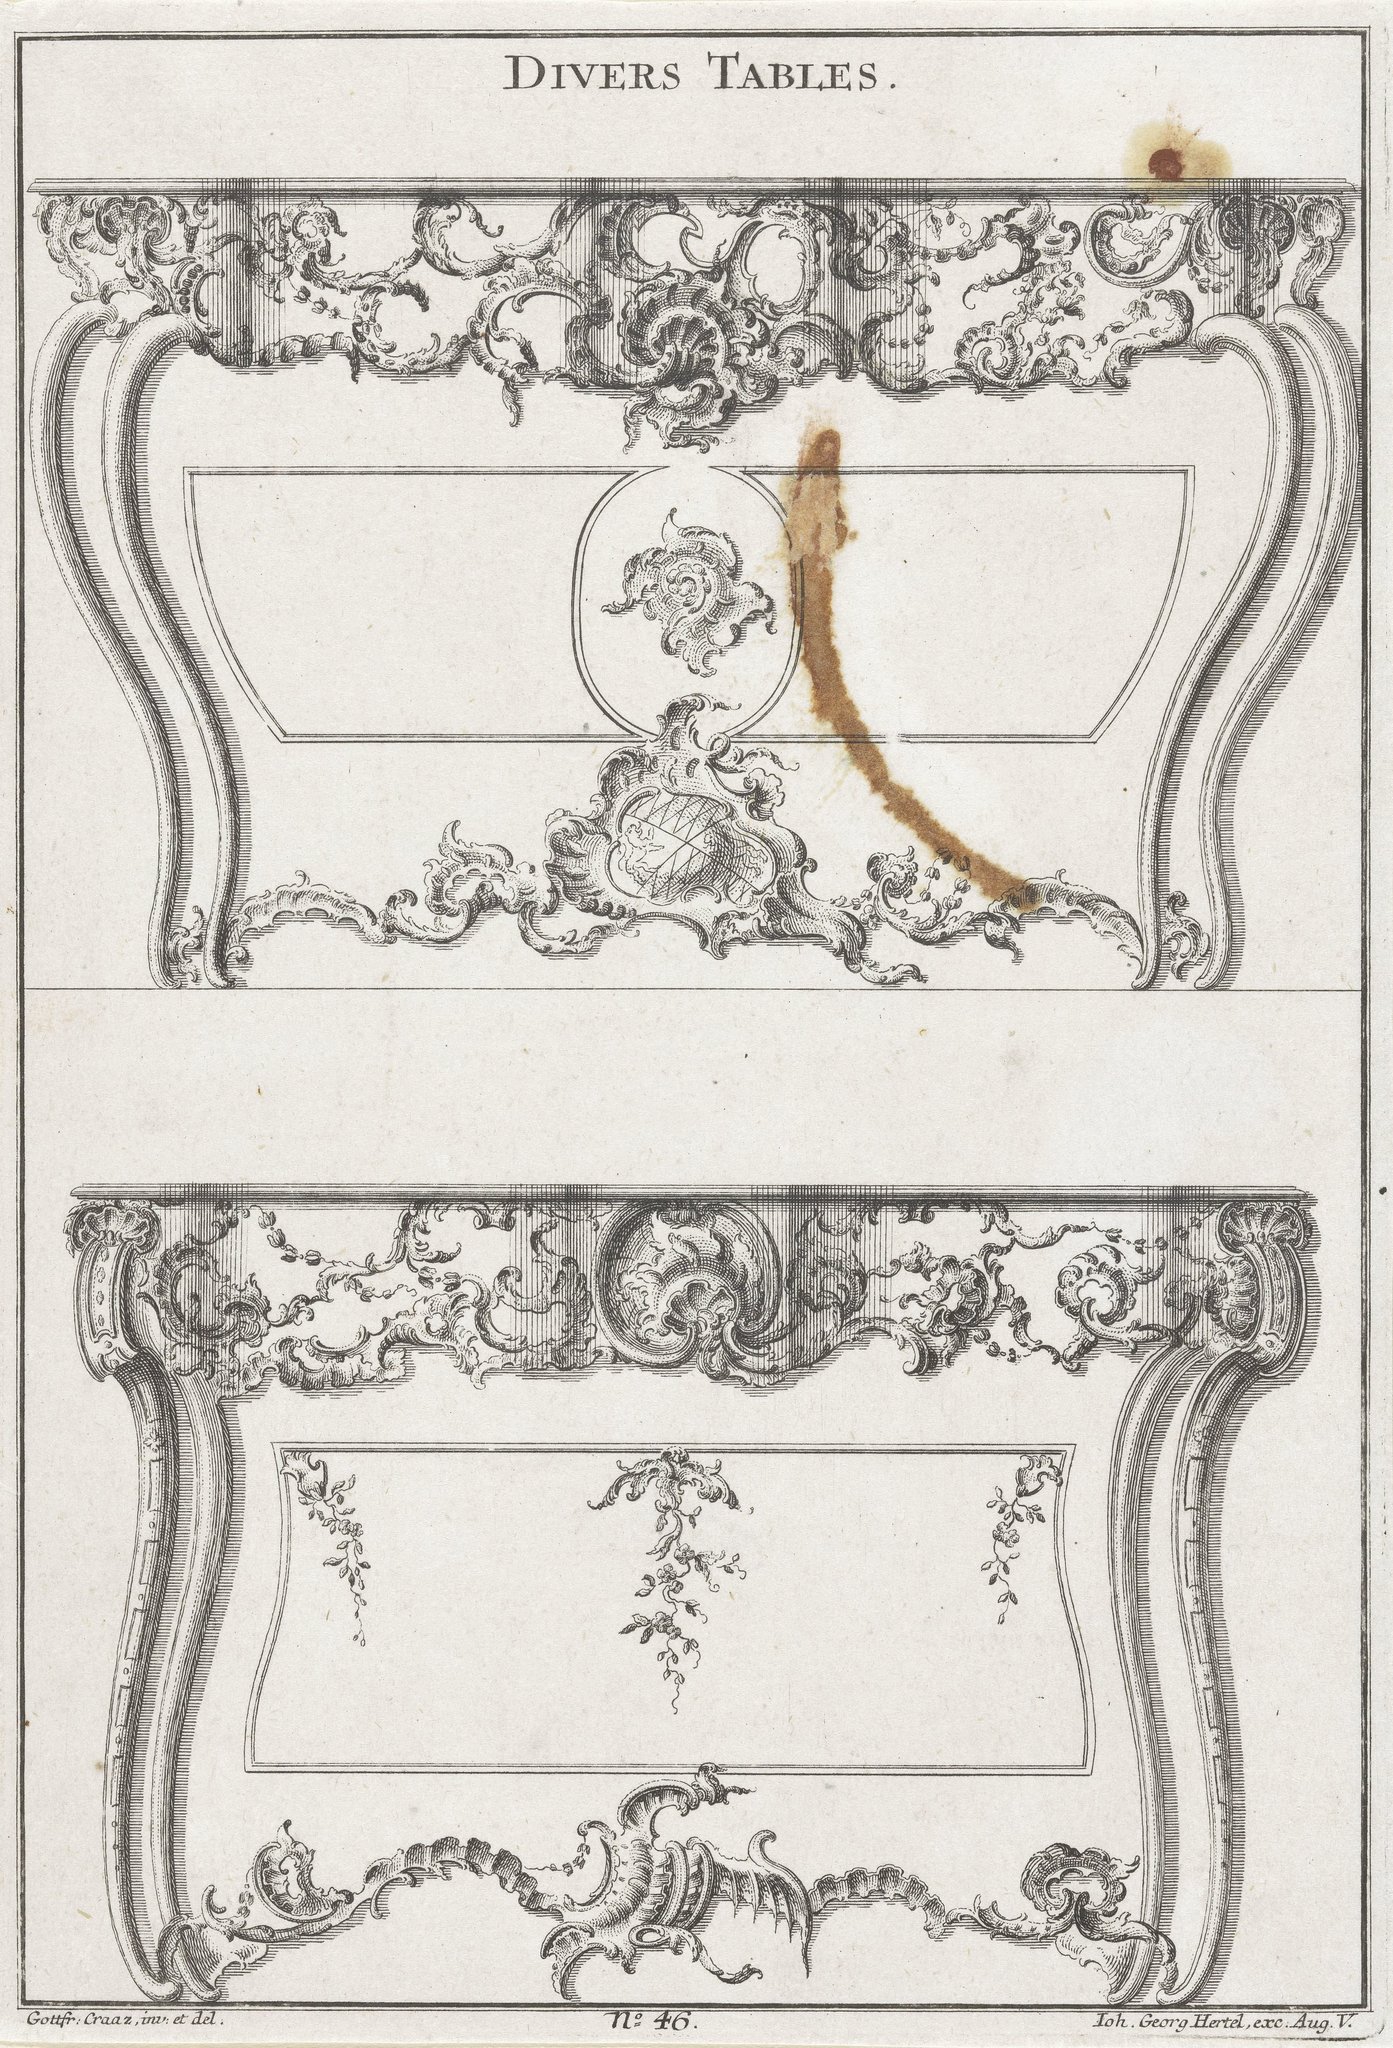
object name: print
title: Divers Tables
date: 1730-1775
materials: paper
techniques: etching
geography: germany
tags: rocaille ornament, table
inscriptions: collector's mark: Lugt 2228, collector's mark: Lugt 2760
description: De tafels hebben elk vier poten. De onderstellen zijn versierd met rocailles. Midden onder 46 genummerd. Deze prent maakt deel uit van een serie van vier.